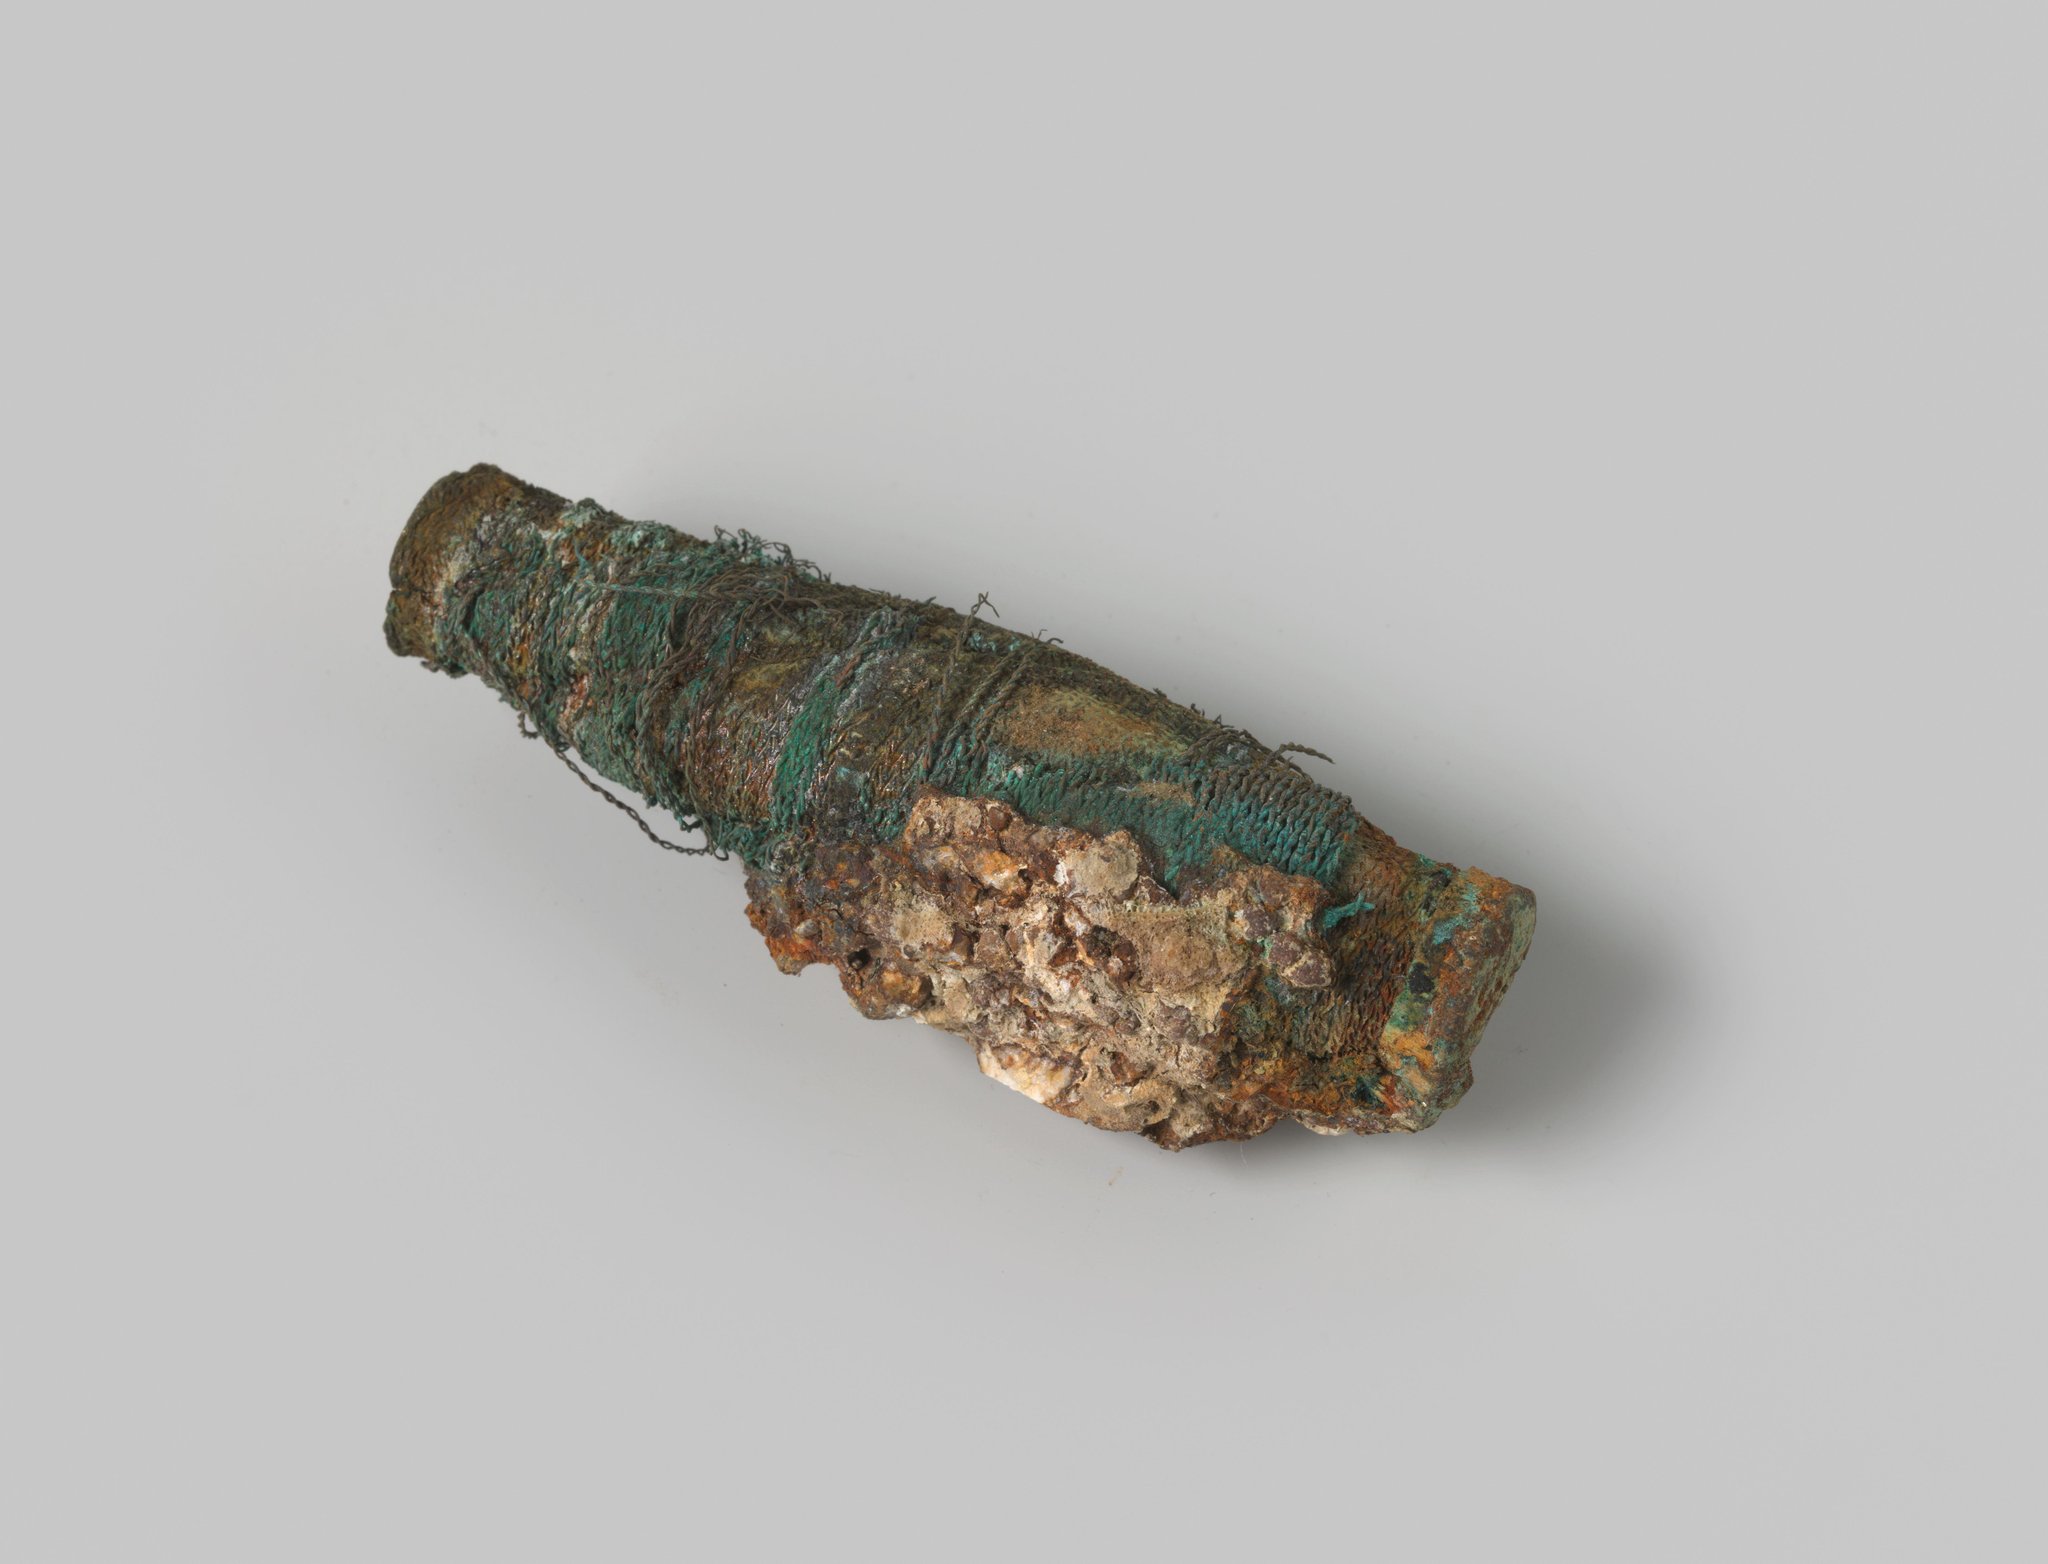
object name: greep gevest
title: Greep met concretie van een gevest uit het wrak van de Oost-Indiëvaarder Hollandia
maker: Anonymous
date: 1700-1743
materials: stone, copper, wood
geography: netherlands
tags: verenigde oostindische compagnie, hollandia (schip), annet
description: Hilt, grip; id. NG 1980-27H2582, 1 ferrule missing.